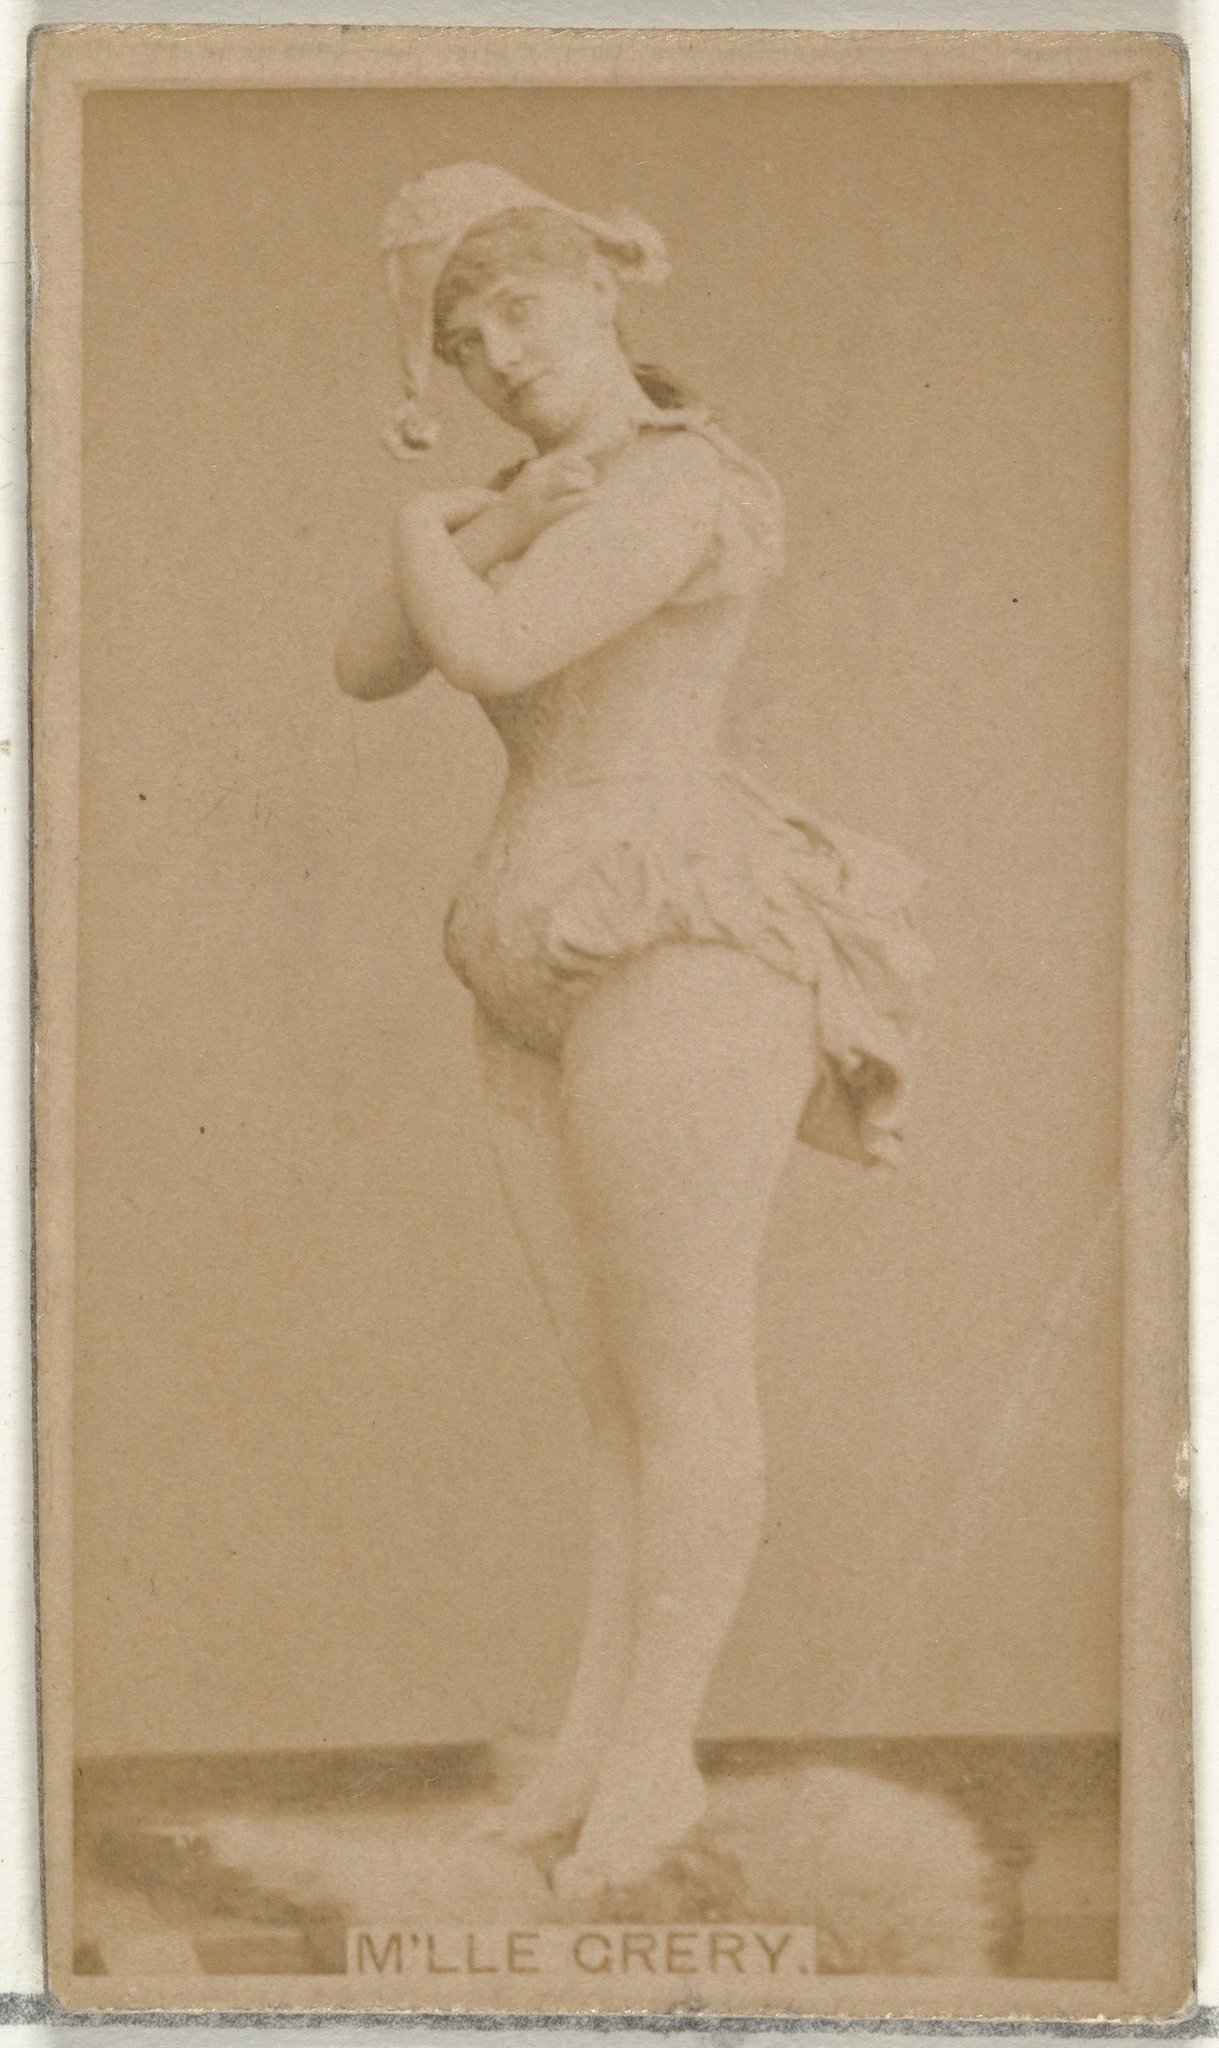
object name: photograph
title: M'lle Crery, from the Actors and Actresses series (N145-8) issued by Duke Sons & Co. to promote Duke Cigarettes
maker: w. duke, sons & co.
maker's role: publisher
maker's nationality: american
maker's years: 1870-1920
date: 1891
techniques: albumen silver print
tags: portraits,women,actresses